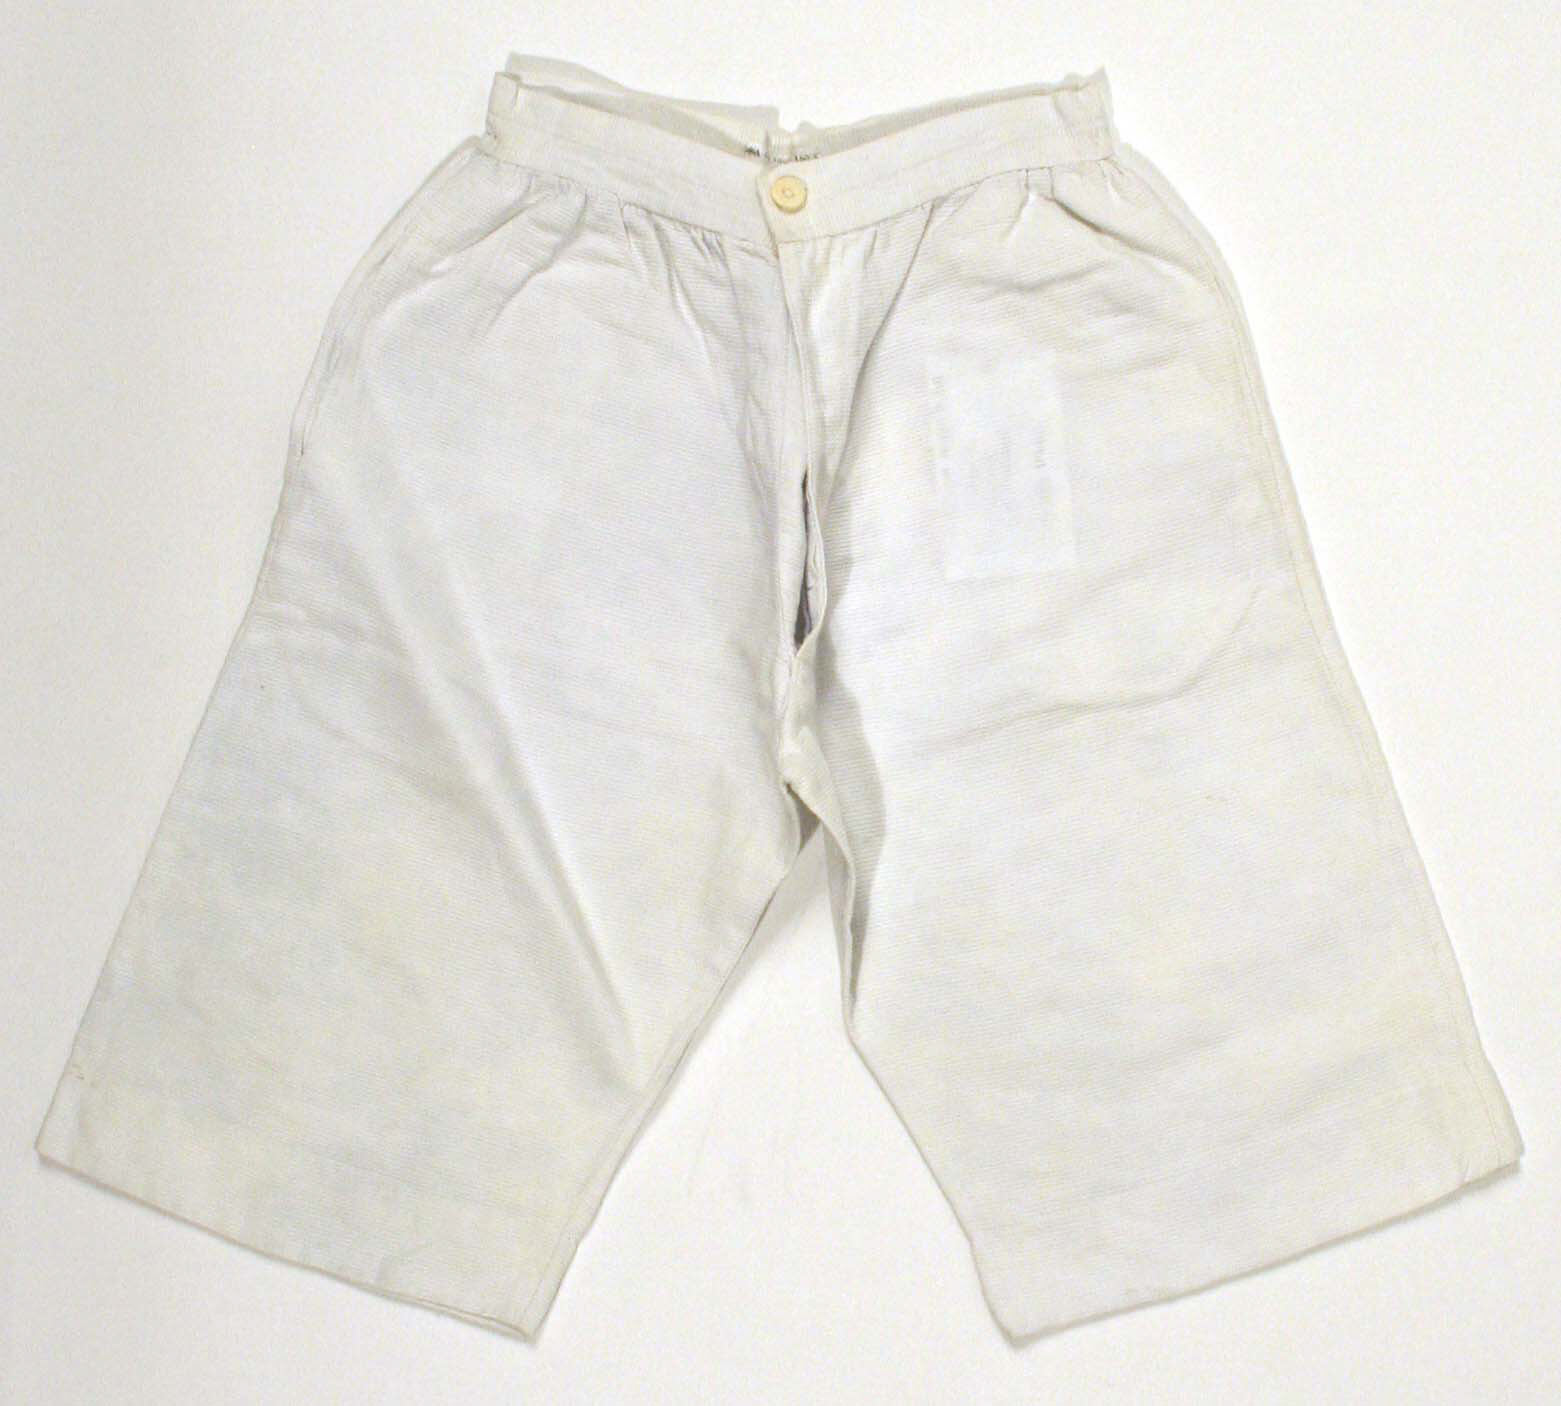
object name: trouser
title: Trousers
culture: american or european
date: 1840-1849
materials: cotton